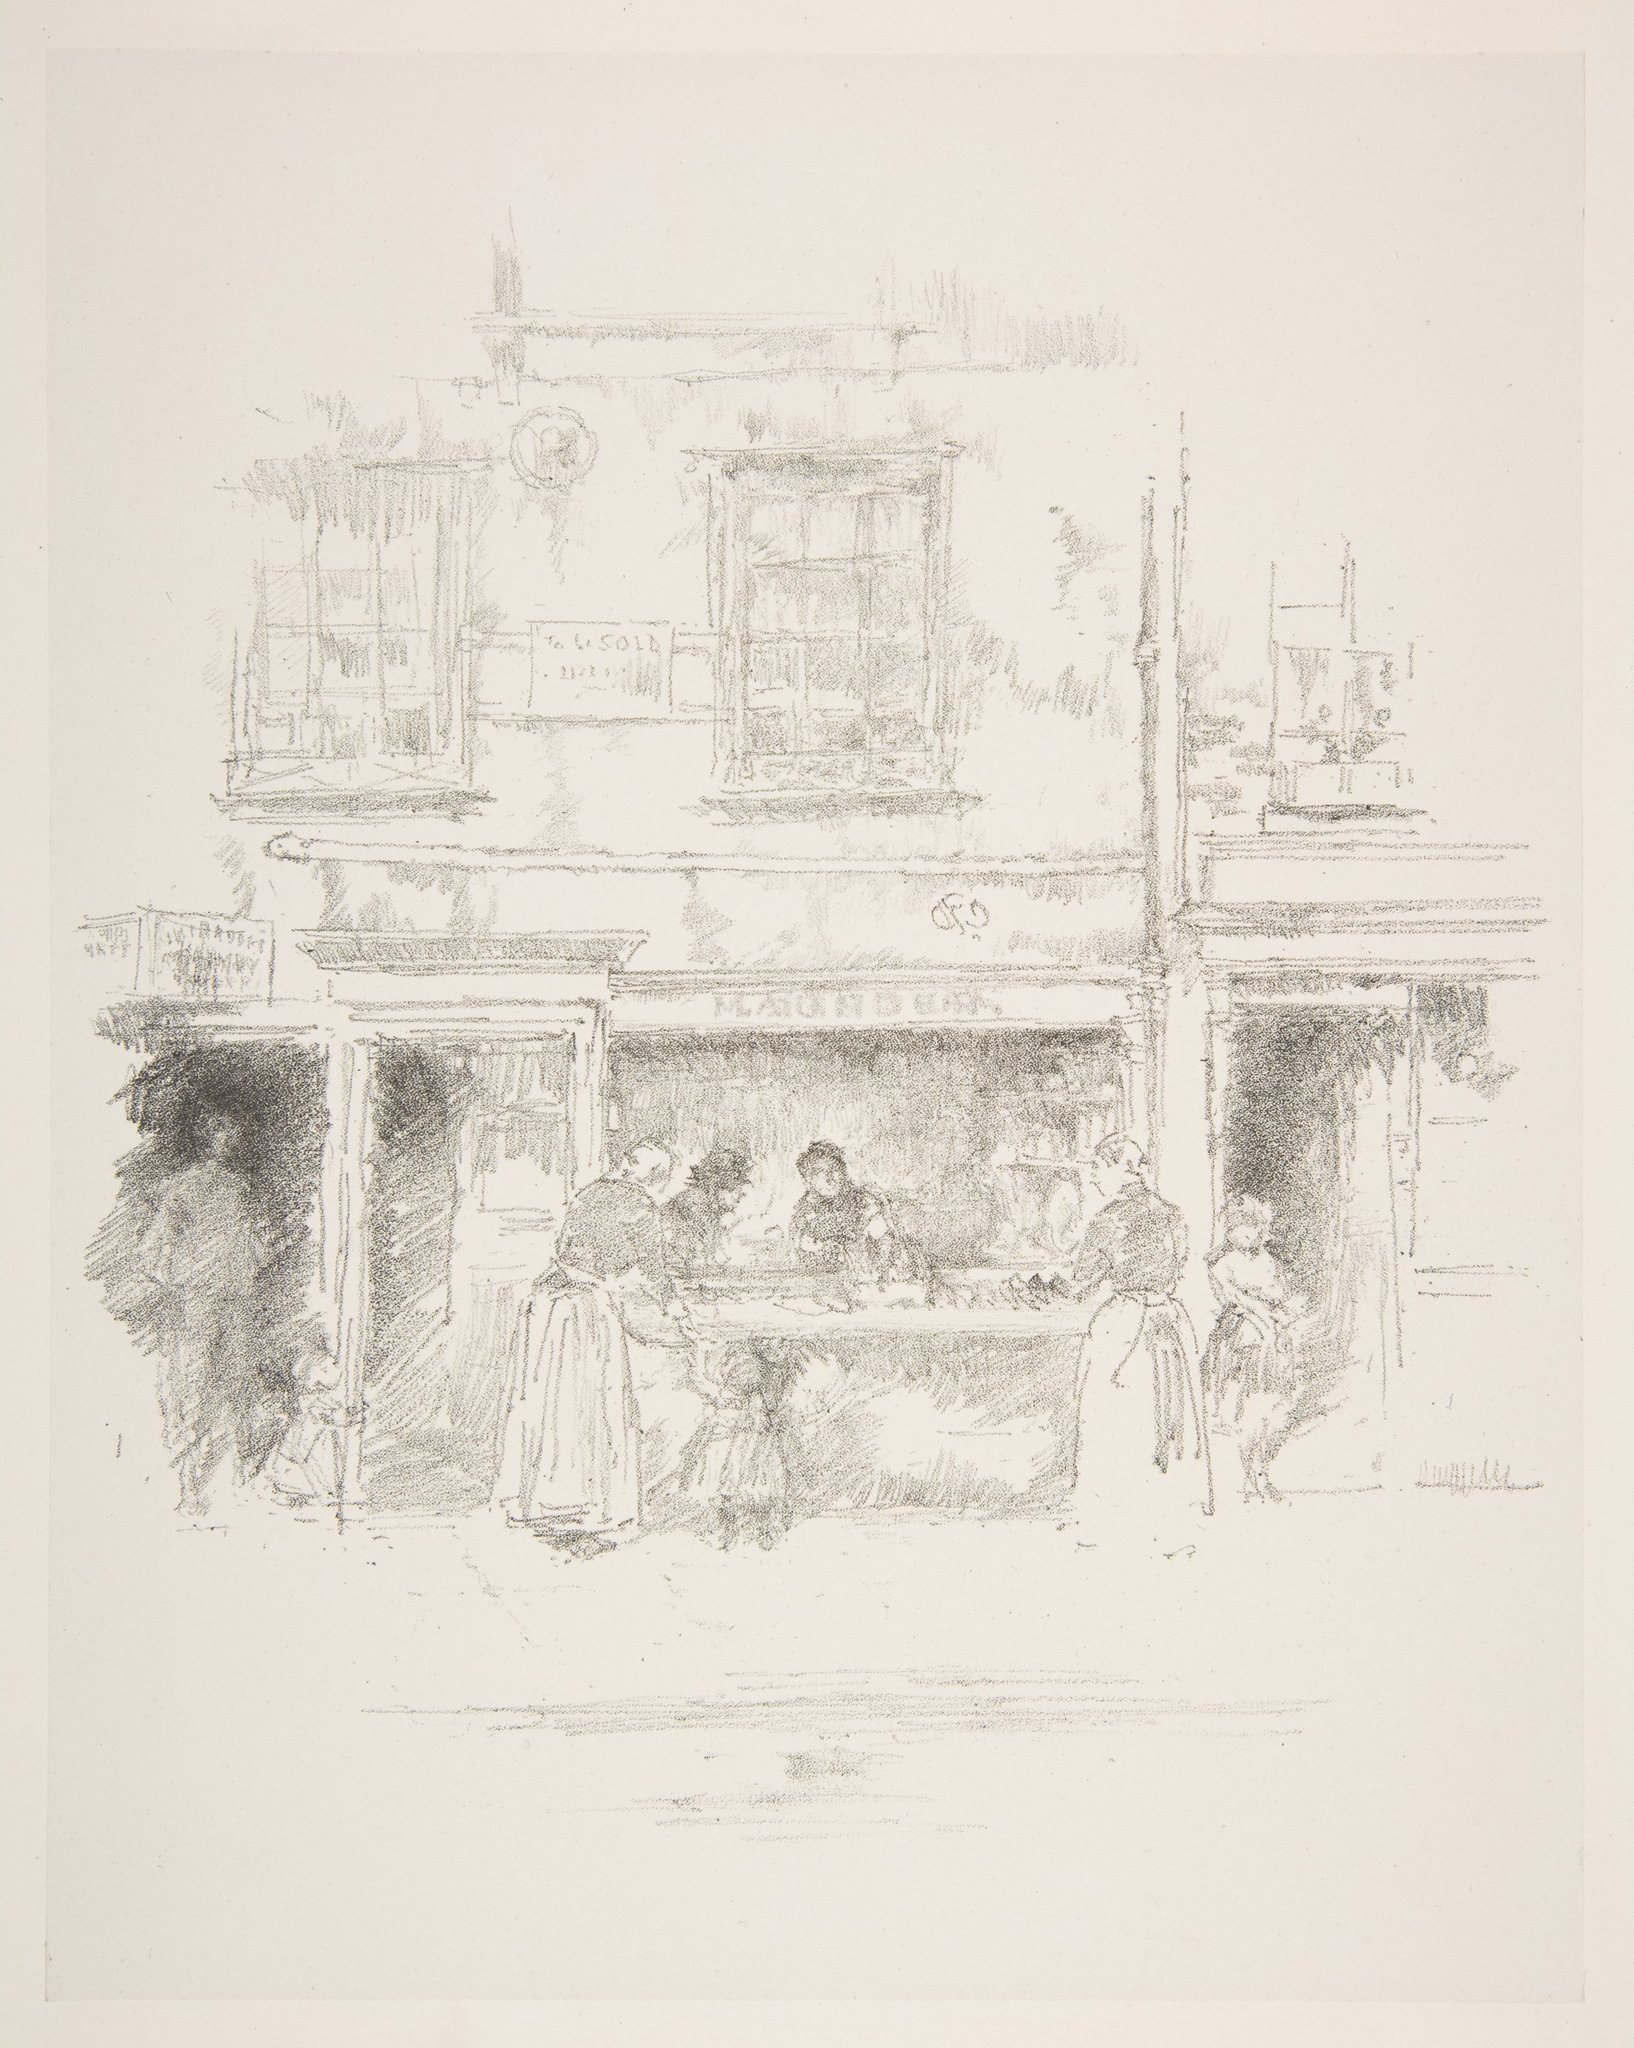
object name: print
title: Maunder's Fish Shop, Chelsea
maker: james mcneill whistler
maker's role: artist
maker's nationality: american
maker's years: 1834-1903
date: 1890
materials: ink, paper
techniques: printing, scraping, lithography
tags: buildings,children,women,daily life